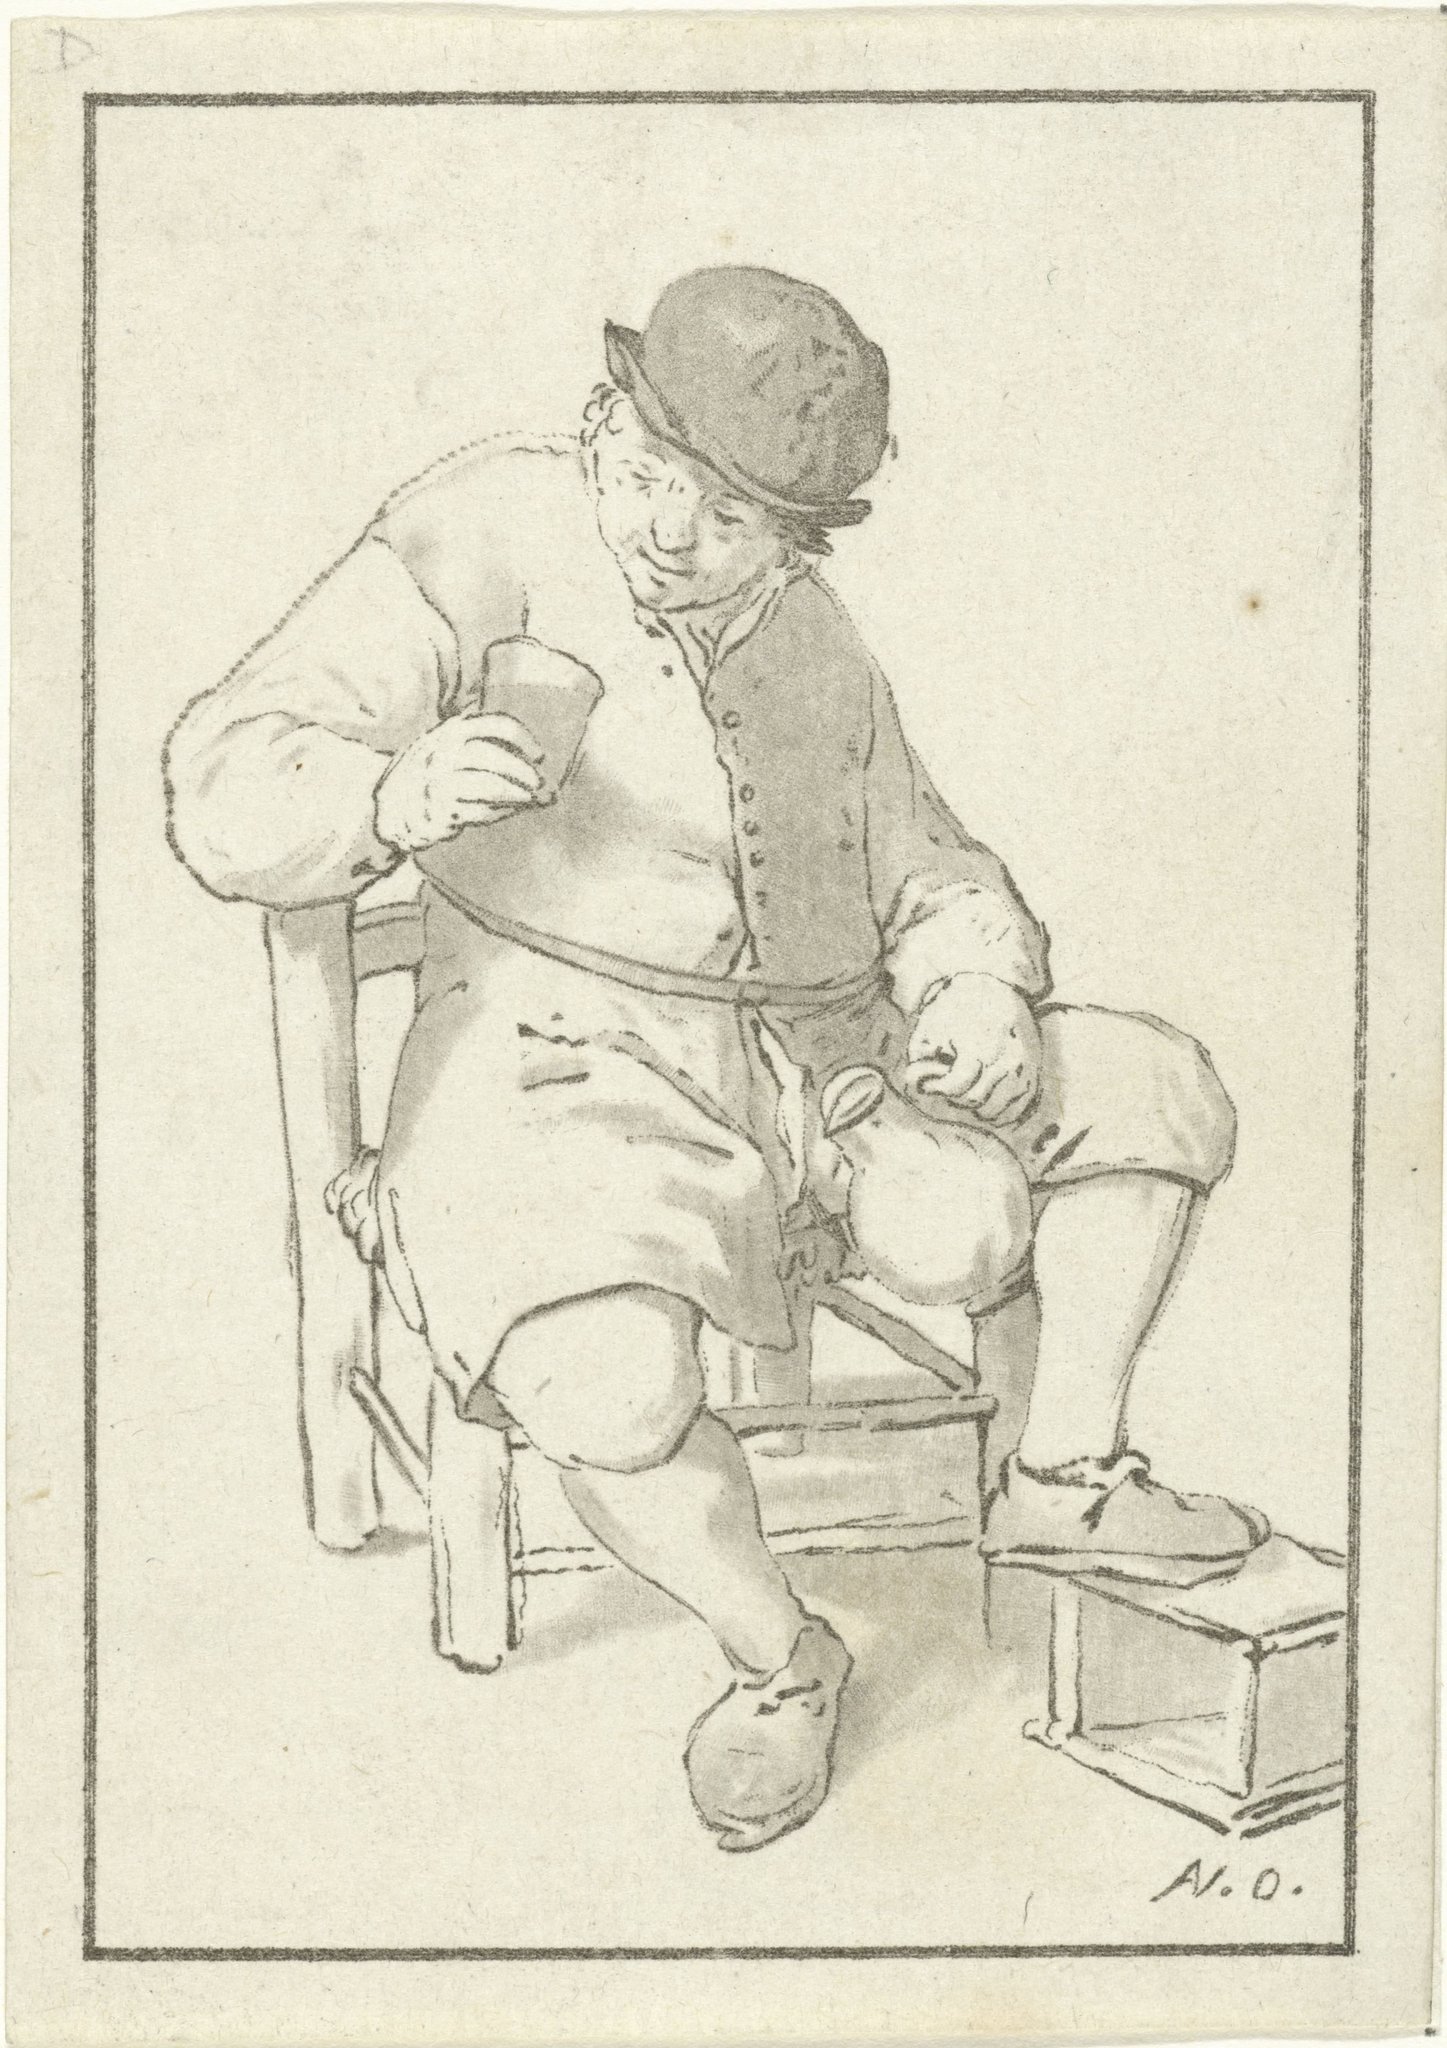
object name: print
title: Zittende boer met kruik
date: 1763-1768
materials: paper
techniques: etching, roulette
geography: amsterdam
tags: sitting figure, jar, jug (used as drinking-vessel)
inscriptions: collector's mark: Lugt 2228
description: Voor deze prenttekening, 'Zittende boer met kruik', maakte Ploos van Amstel vier verschillende platen (A, B, C, en D). Er bestaan afdrukken van één, twee, drie of alle vier de platen in alle mogelijke combinaties. Zie gerelateerde objecten voor de hier gebruikte plaat.